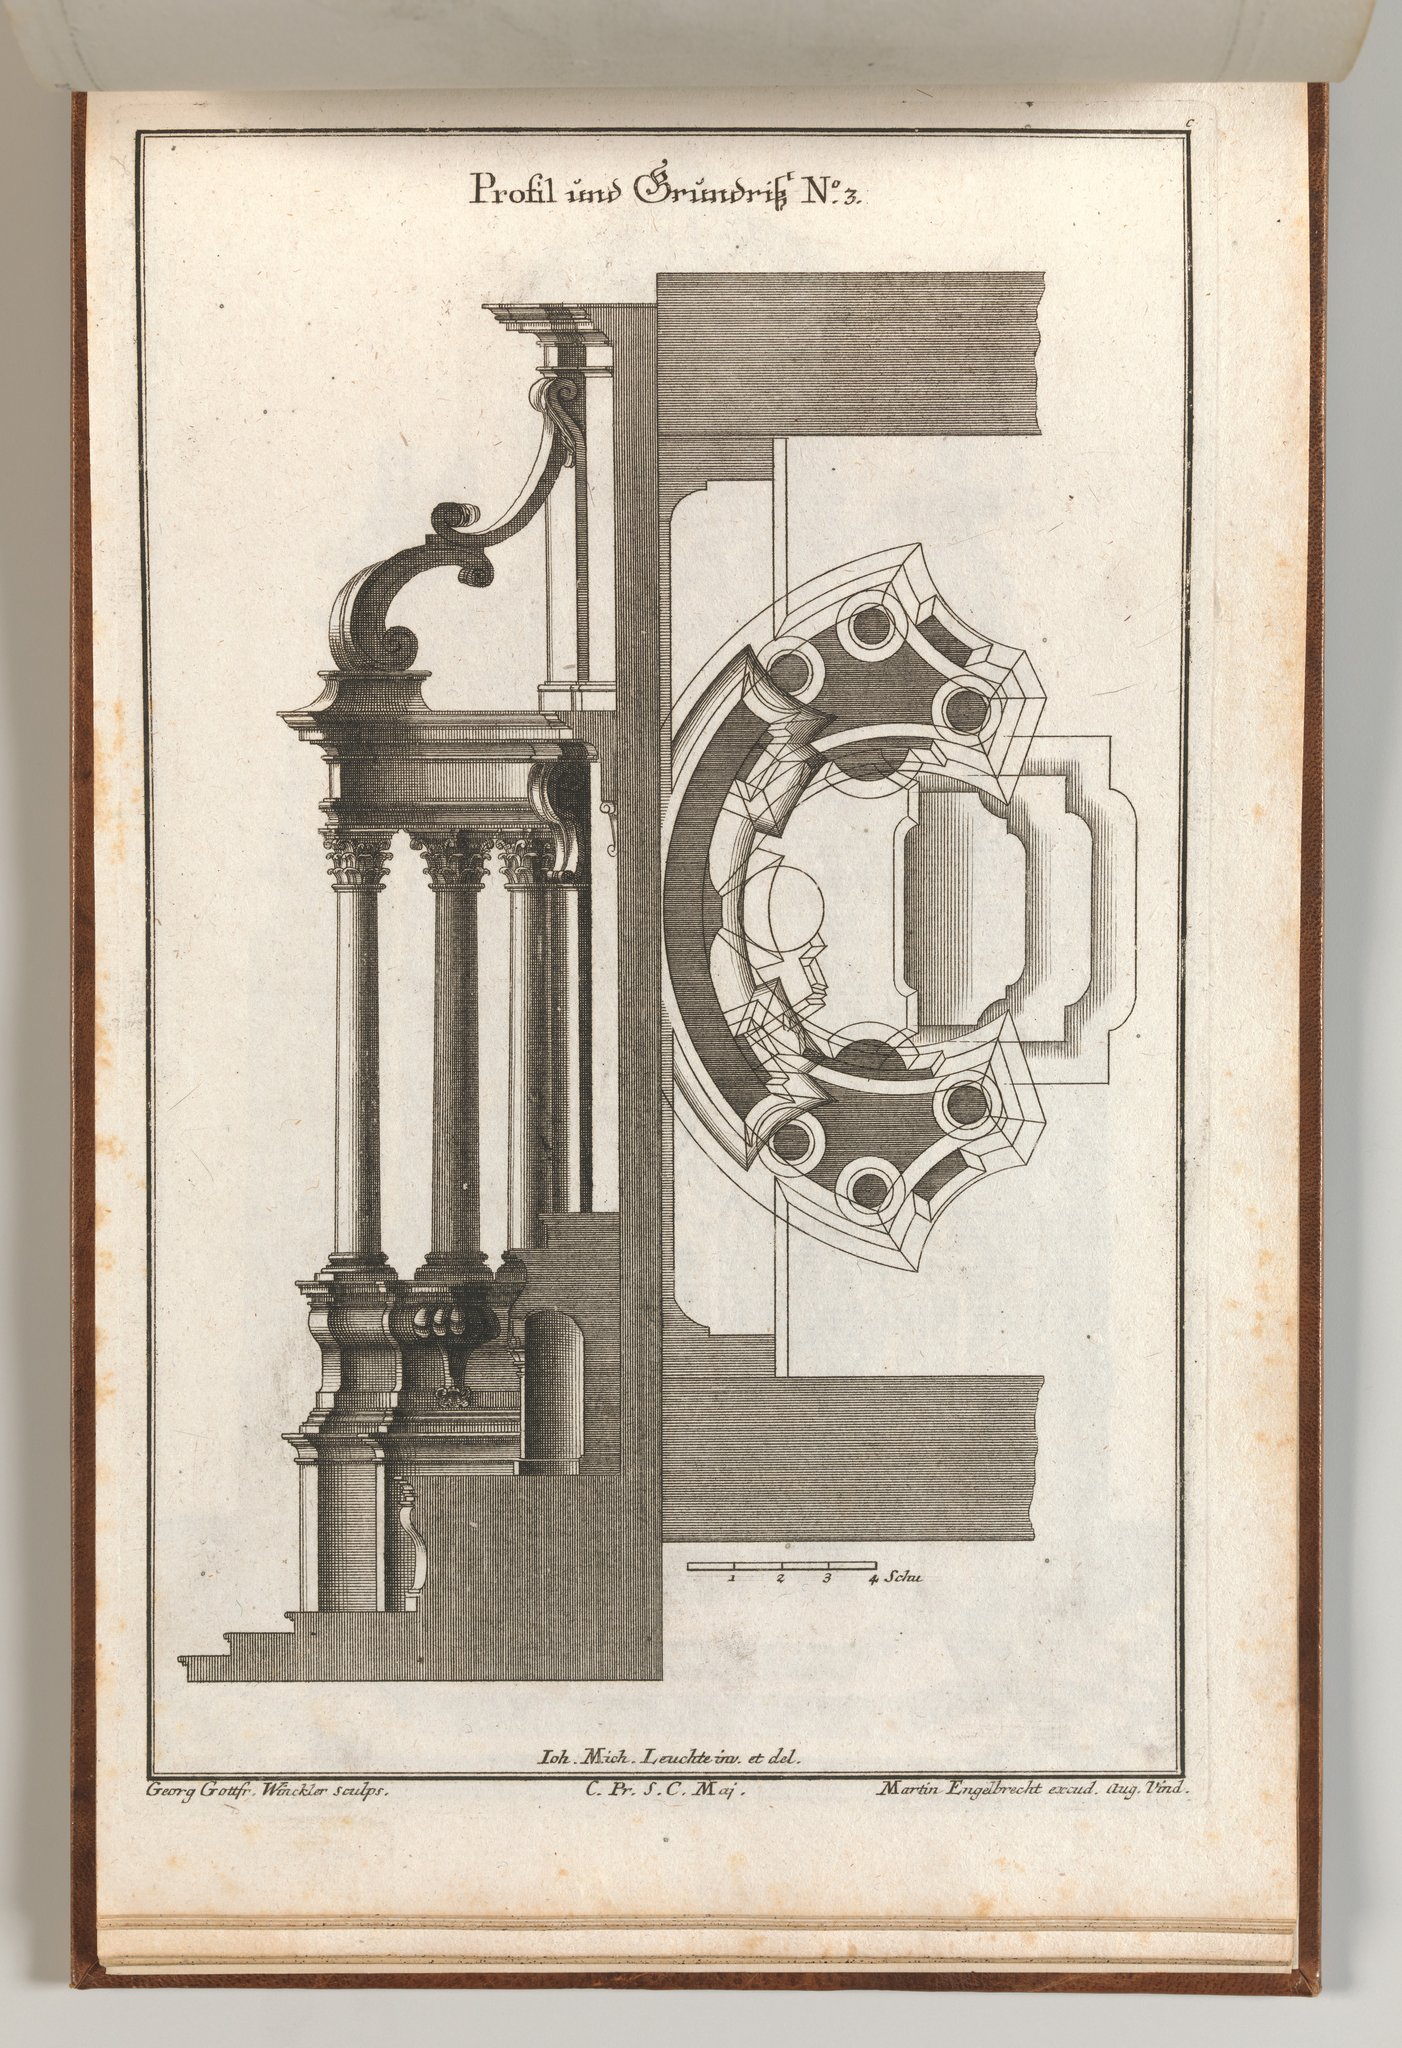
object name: album print ornament architecture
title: Floorplan and Side View of an Altar, Plate c (2) from 'Unterschiedliche Neu Inventierte Altäre mit darzu gehörigen Profillen u. Grundrißen.'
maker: georg gottfried winckler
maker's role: engraver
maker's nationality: german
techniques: etching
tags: architecture,altars